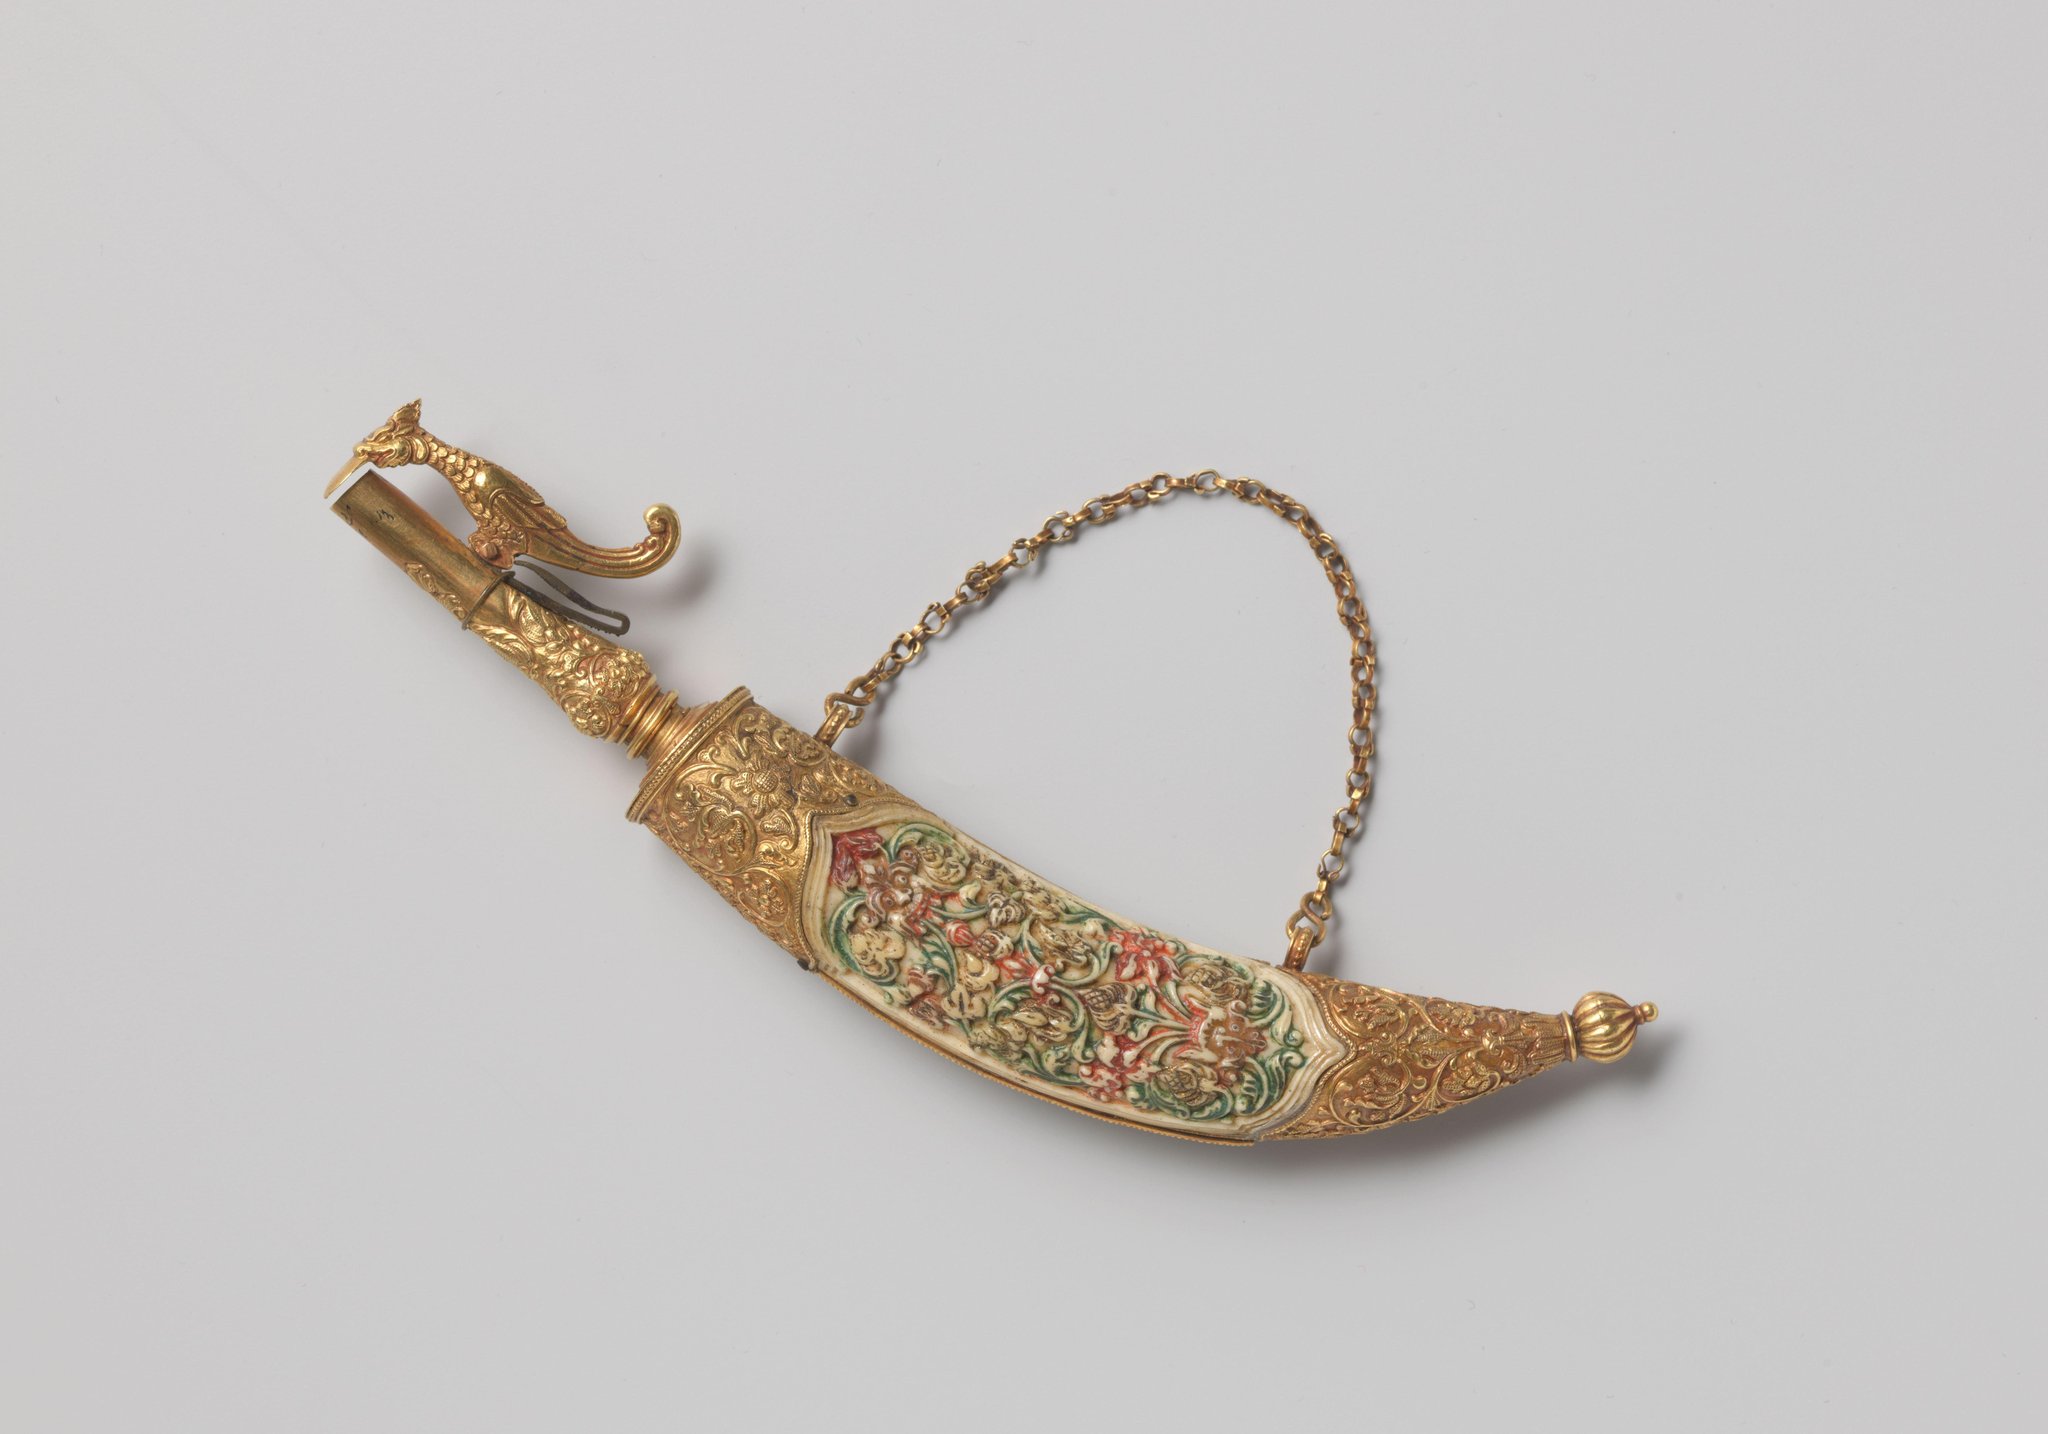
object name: powder horn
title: Sieraad in de vorm van een dolkschede van gesneden en gekleurd ivoor in een montuur van edelmetaal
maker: Anonymous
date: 1700-1800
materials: gold, ivory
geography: south india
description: Sieraad in de vorm van een dolkschede van gesneden en gekleurd ivoor in een montuur van rijk versierd edelmetaal. Met gouden ketting.